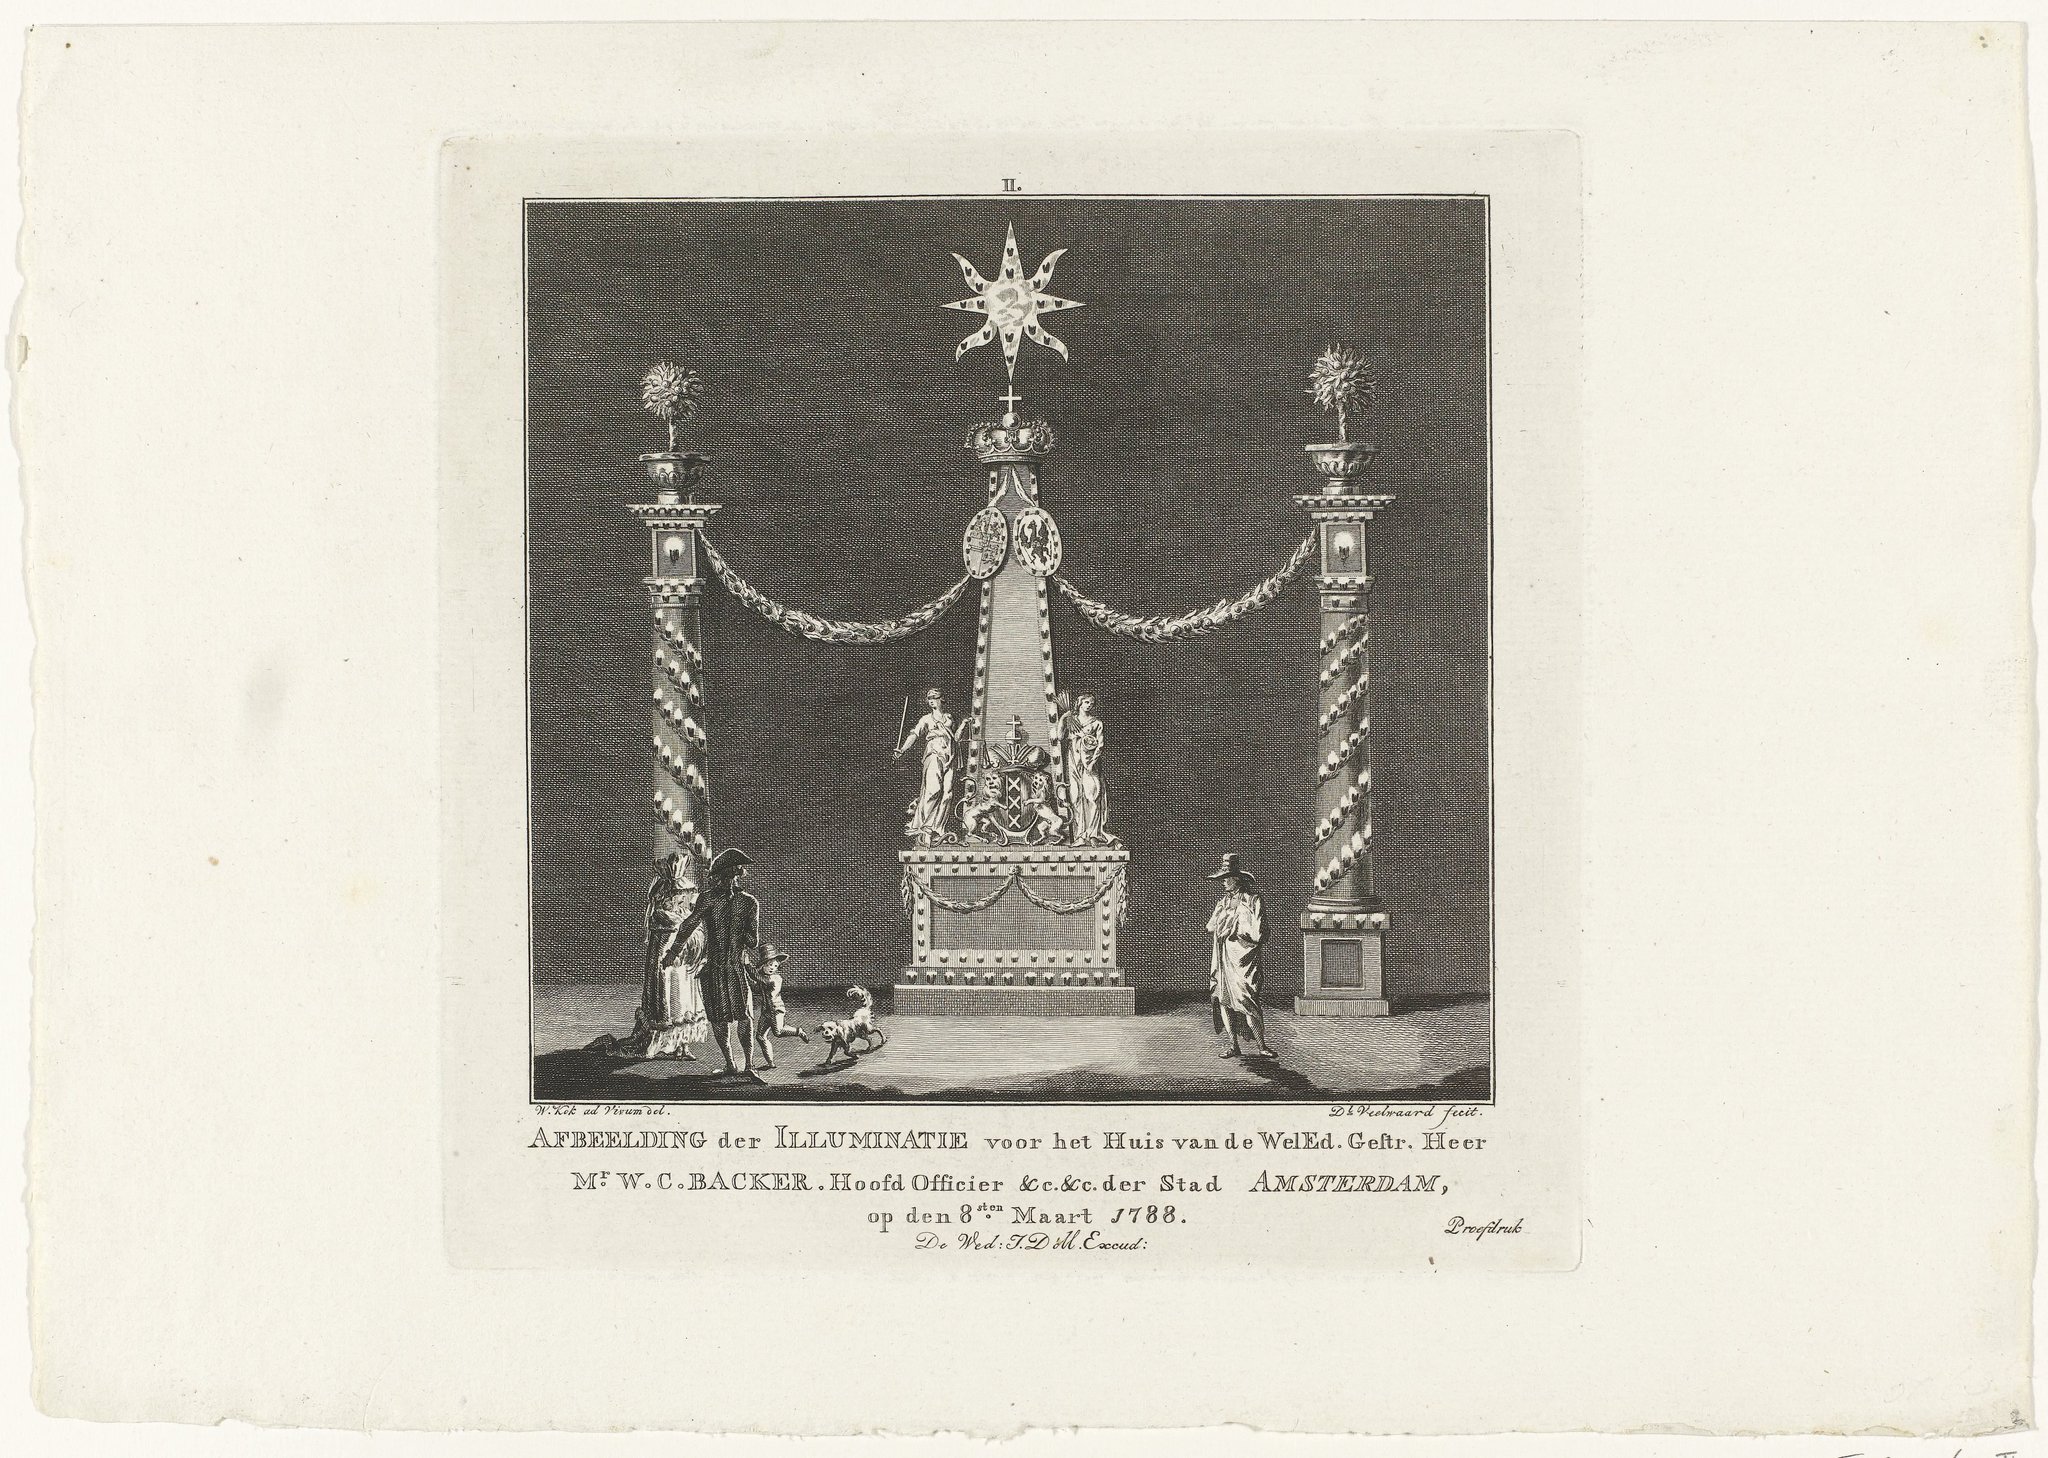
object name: print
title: Illuminatie voor het huis van mr. W.C. Backer te Amsterdam, 1788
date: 1788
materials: paper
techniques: engraving, etching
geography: amsterdam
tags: the hague, william v (prince of orange), bonfire, fire-works (+ illumination, fire-works ~ festive activities), amsterdam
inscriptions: collector's mark: Lugt 2228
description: Illuminatie aangebracht voor het huis van mr. W.C. Backer te Amsterdam. Genummerd bovenaan: II. Onderdeel van een reeks van twaalf platen van de illuminaties en decoraties te Amsterdam op de 40ste verjaardag van prins Willem V op 8 maart 1788.